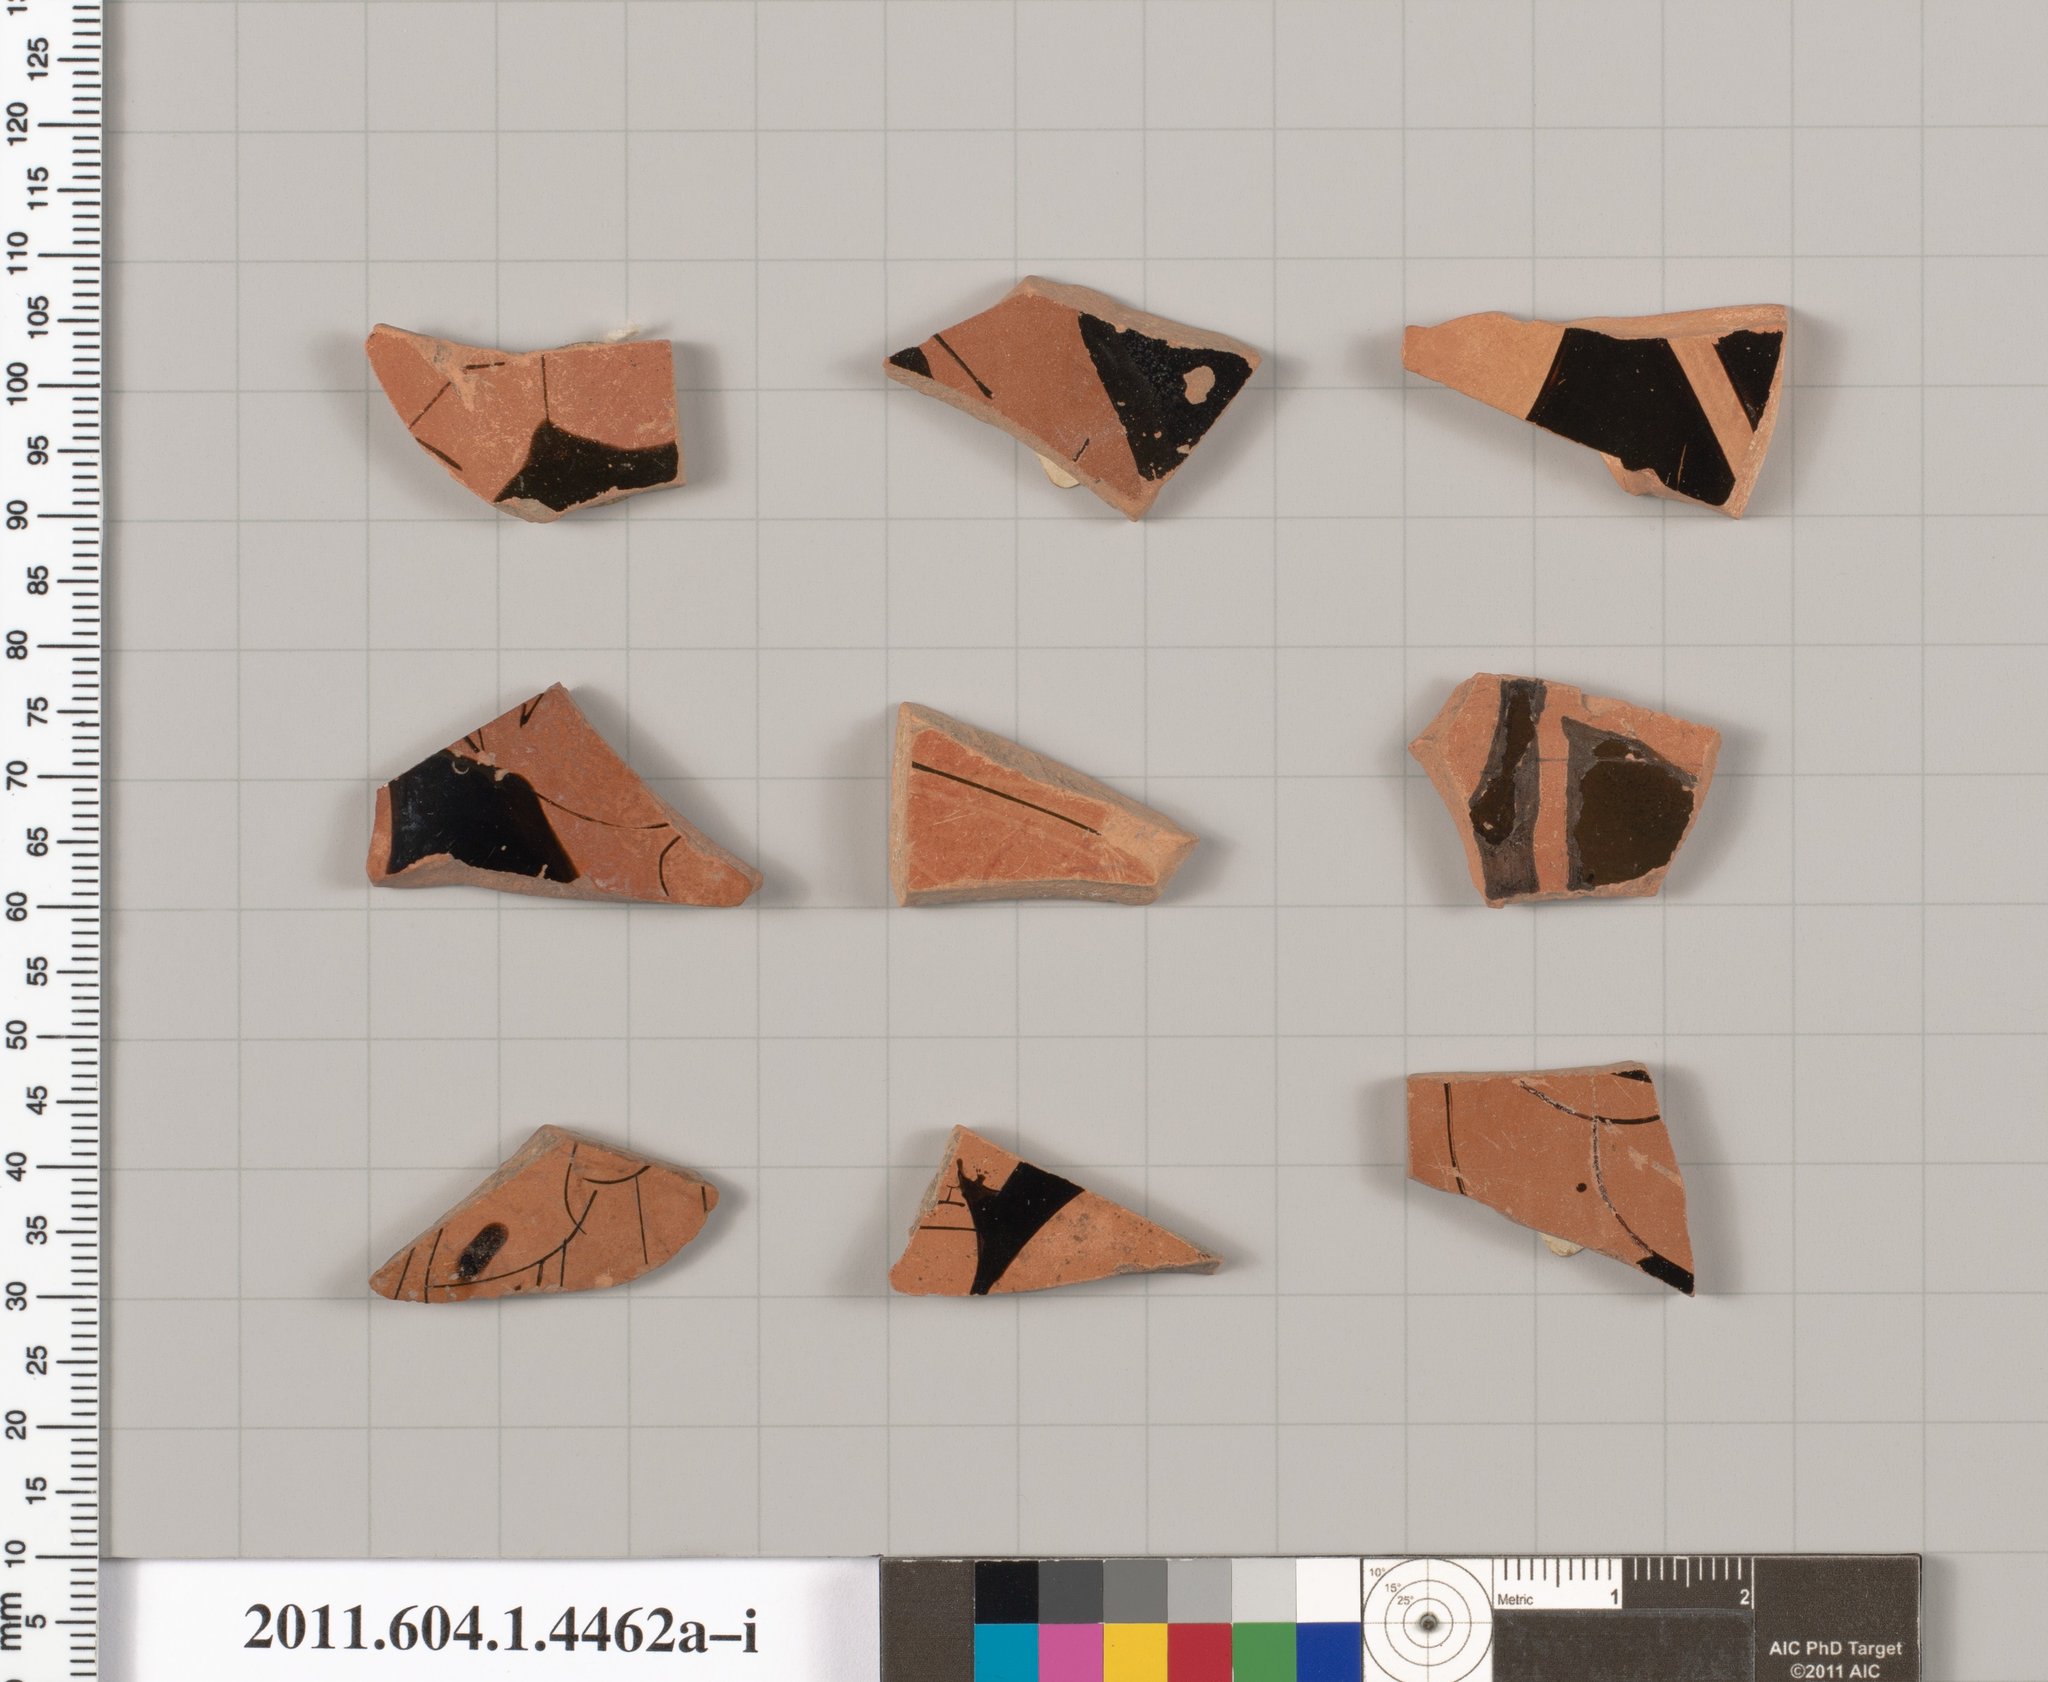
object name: kylix fragment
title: Terracotta fragments of kylikes (drinking cups)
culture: greek, attic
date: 500-451 BCE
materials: terracotta